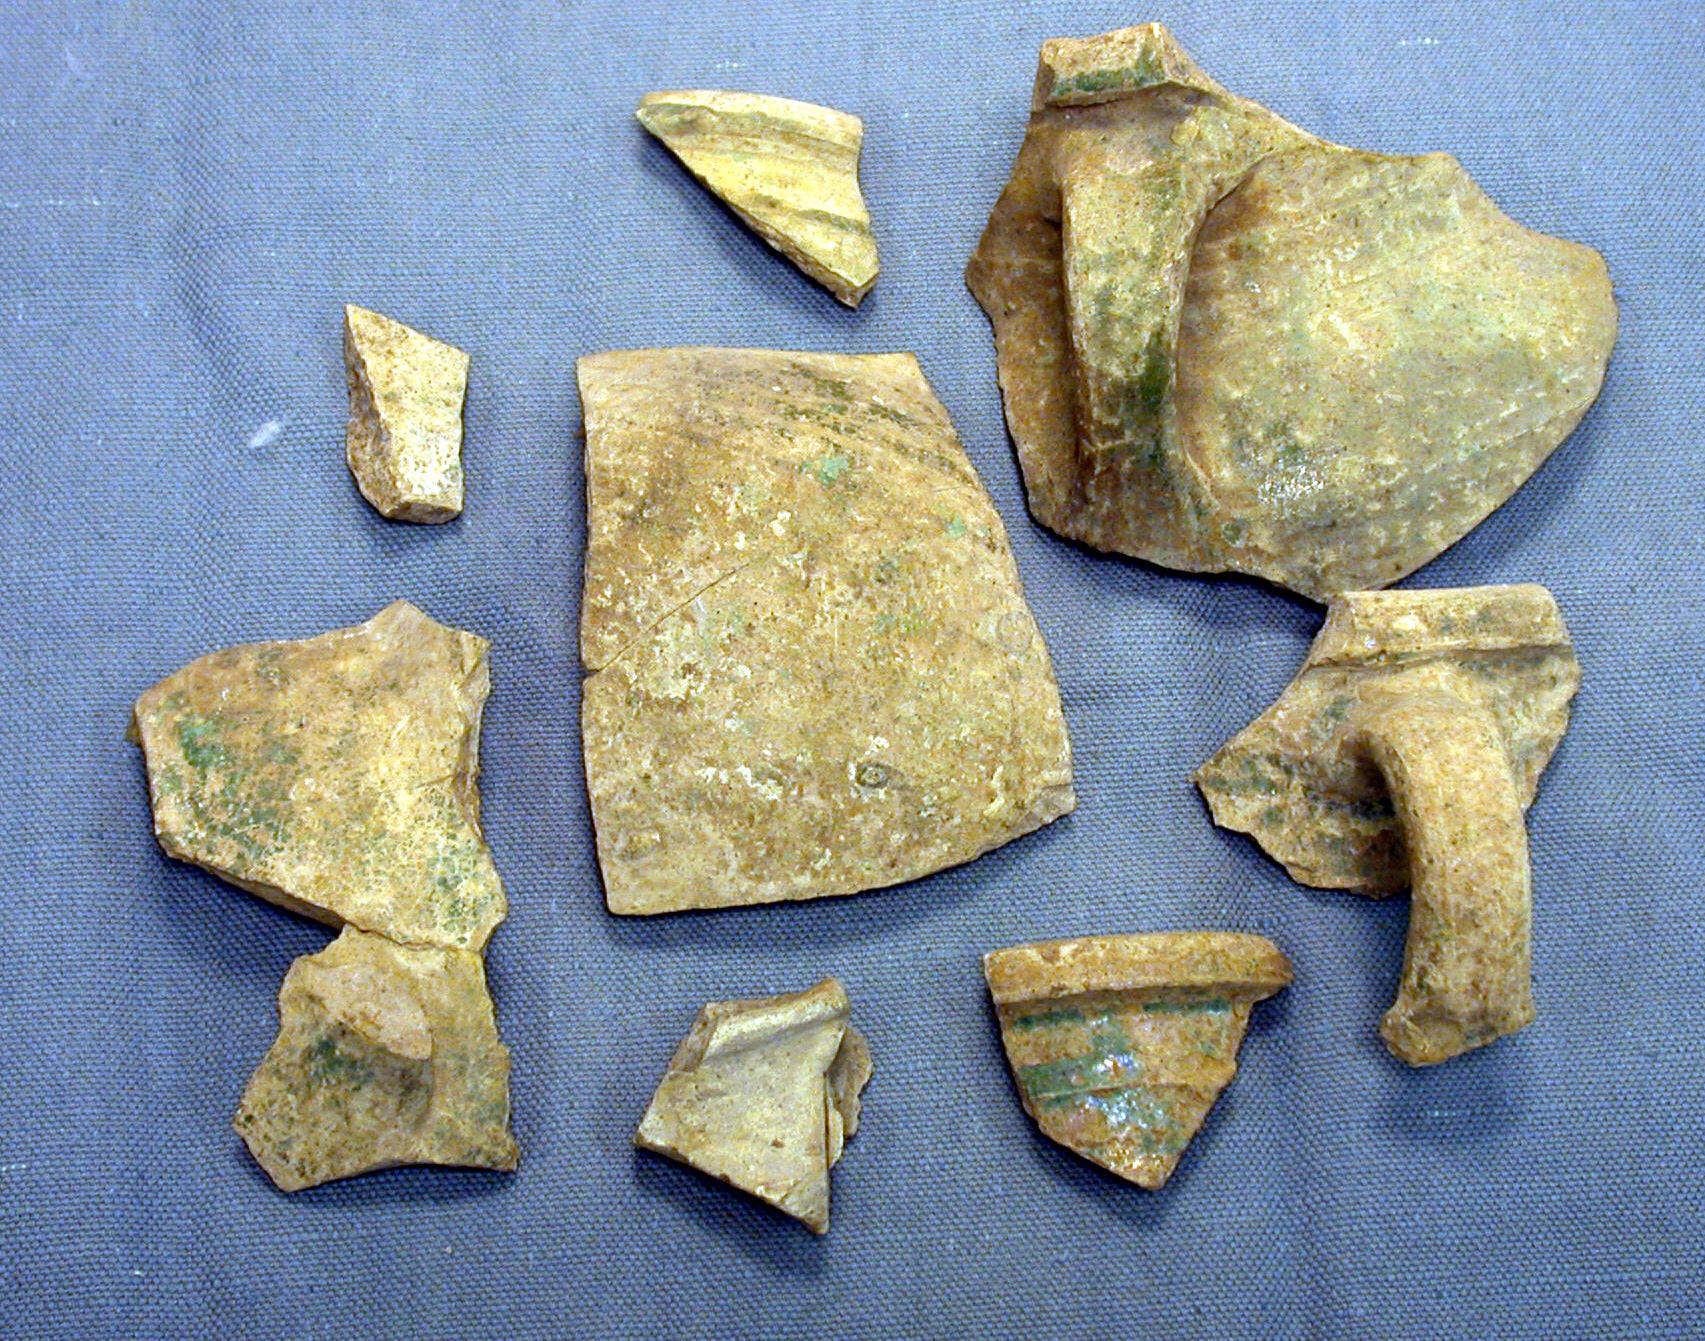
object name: jug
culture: islamic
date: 801-1000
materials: ceramic, glaze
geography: iran